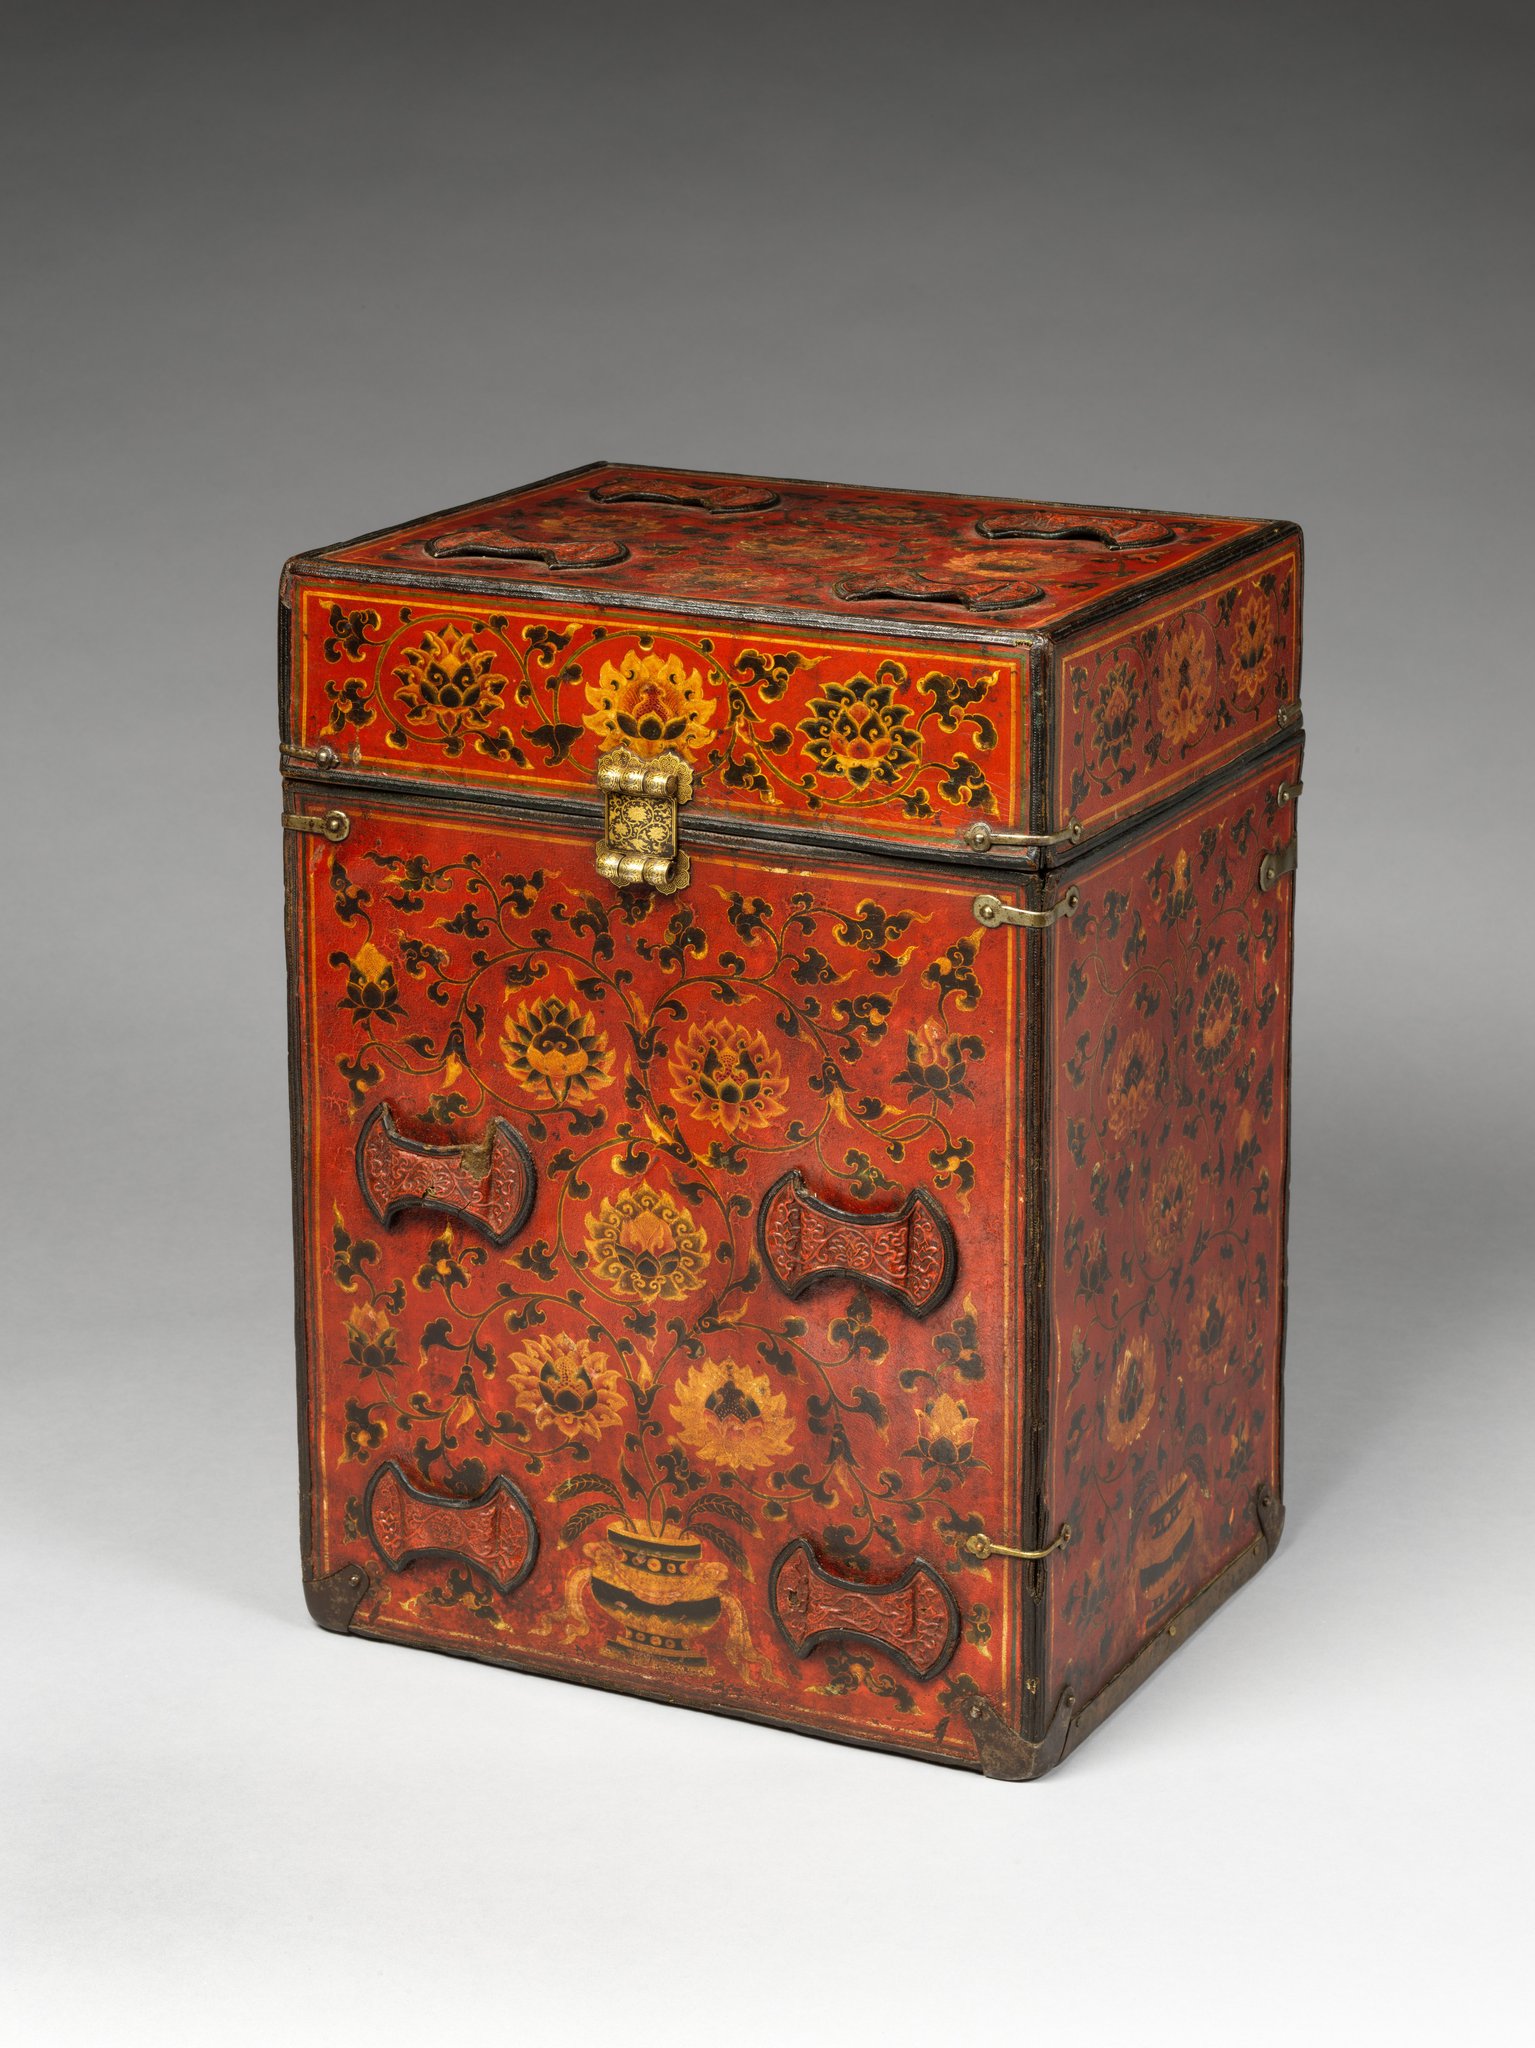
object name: traveling box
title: Traveling box with lotus scrolls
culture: chinese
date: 1401-1433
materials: gold, iron, lacquer, leather, wood